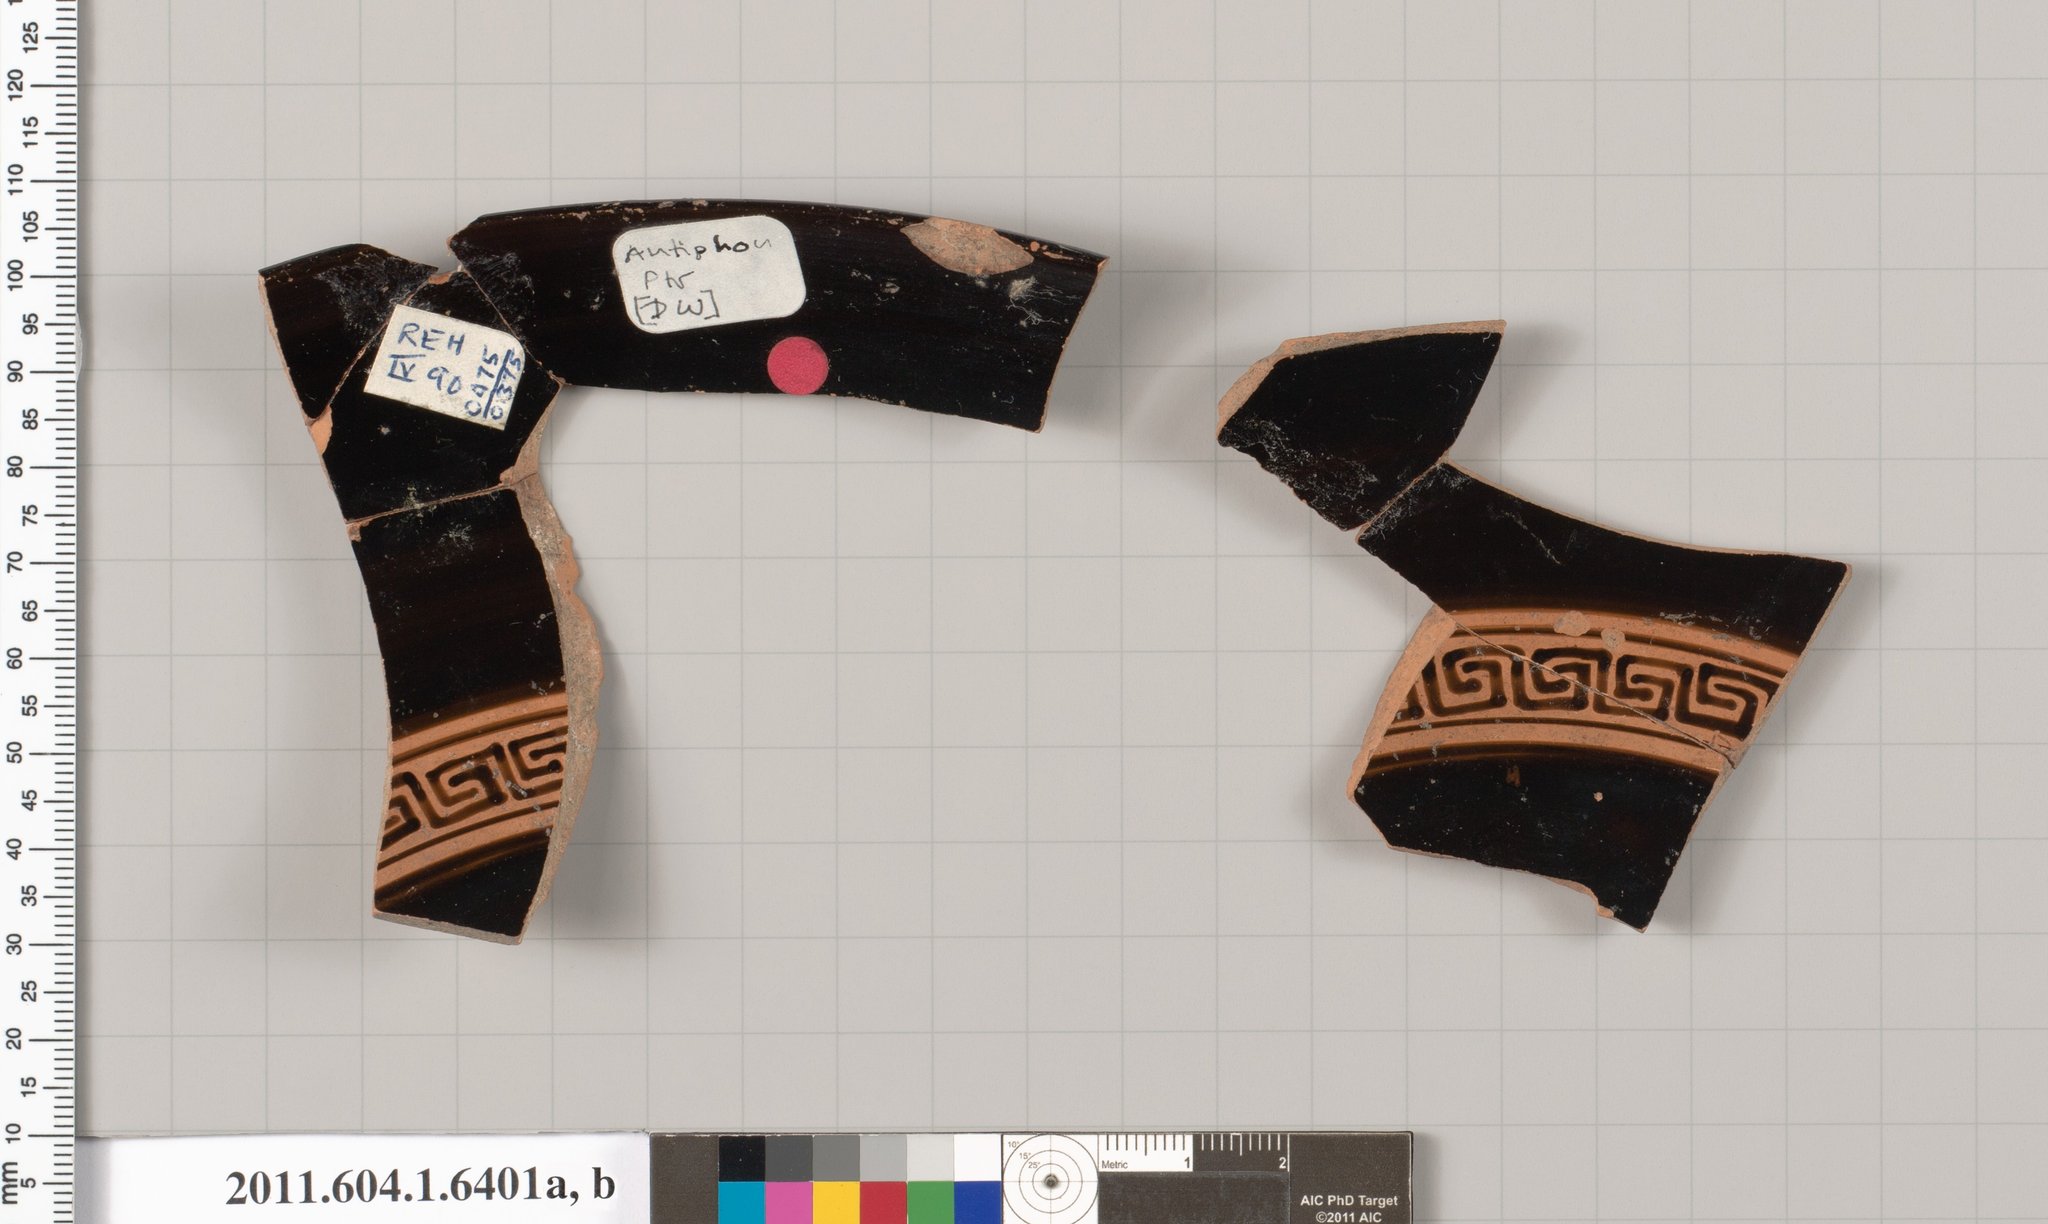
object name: kylix fragment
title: Terracotta rim fragment of a kylix (drinking cup)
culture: greek, attic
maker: antiphon painter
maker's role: artist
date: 490-480 BCE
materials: terracotta